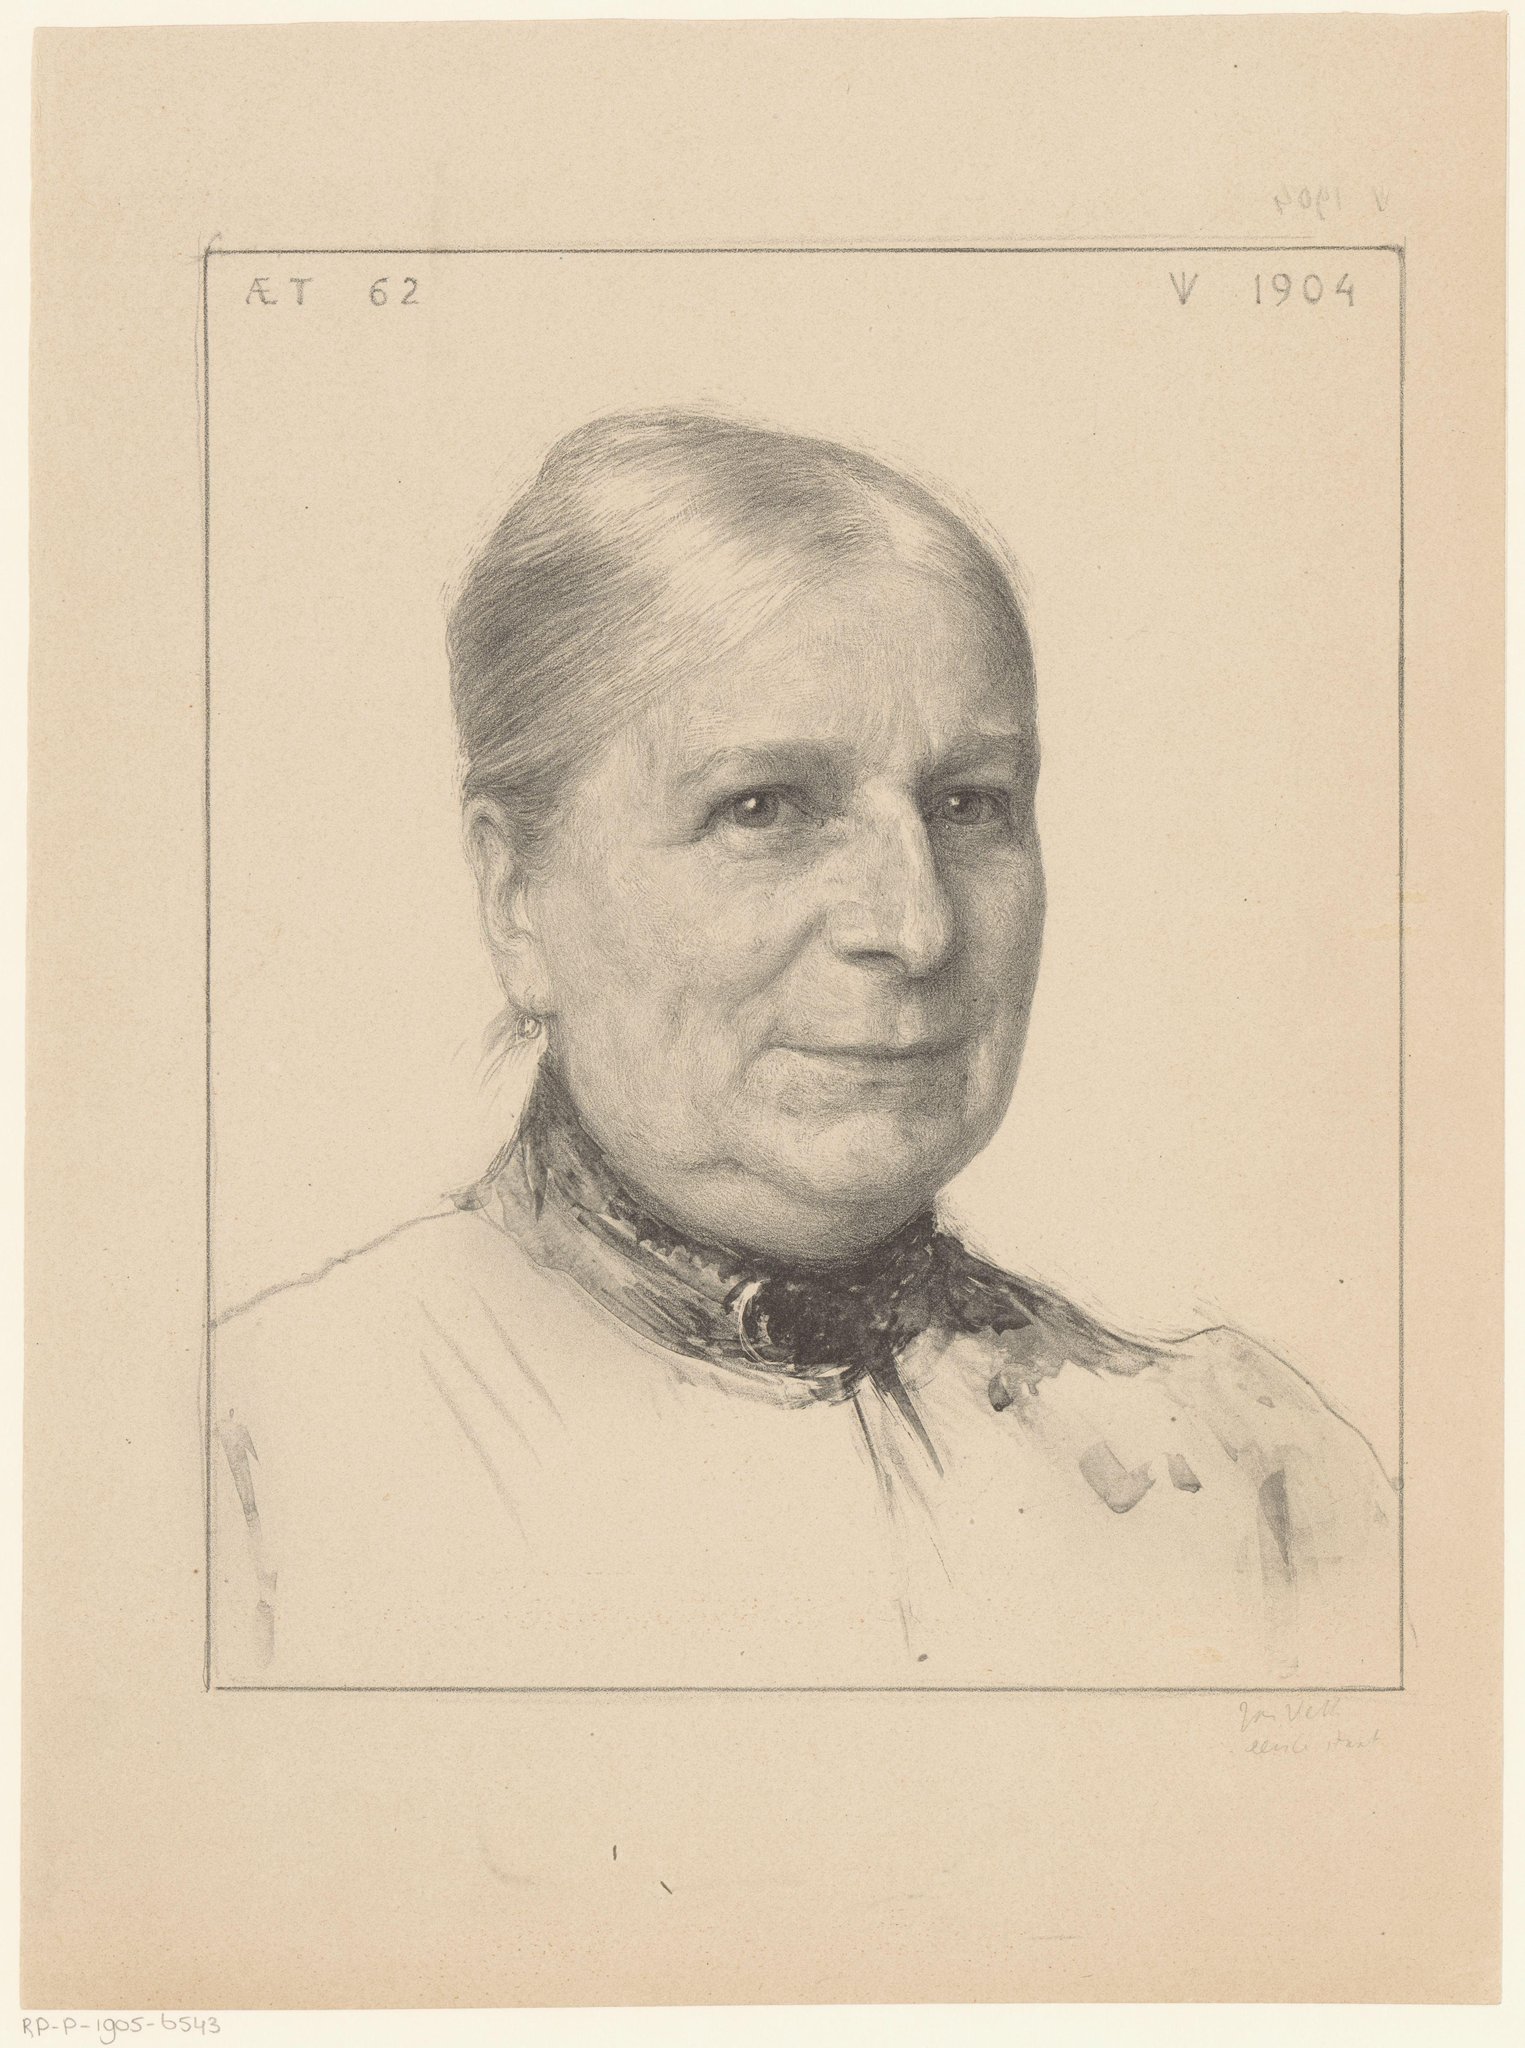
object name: print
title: Portret van Hester den Tex-Boissevain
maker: jan veth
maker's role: designer, draughtsman, painter, print maker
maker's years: 1864-1925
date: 1904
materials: paper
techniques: lithograph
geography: netherlands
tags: historical persons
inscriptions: collector's mark: Lugt 2228, inscription: ‘Jan Veth / eerste staat’